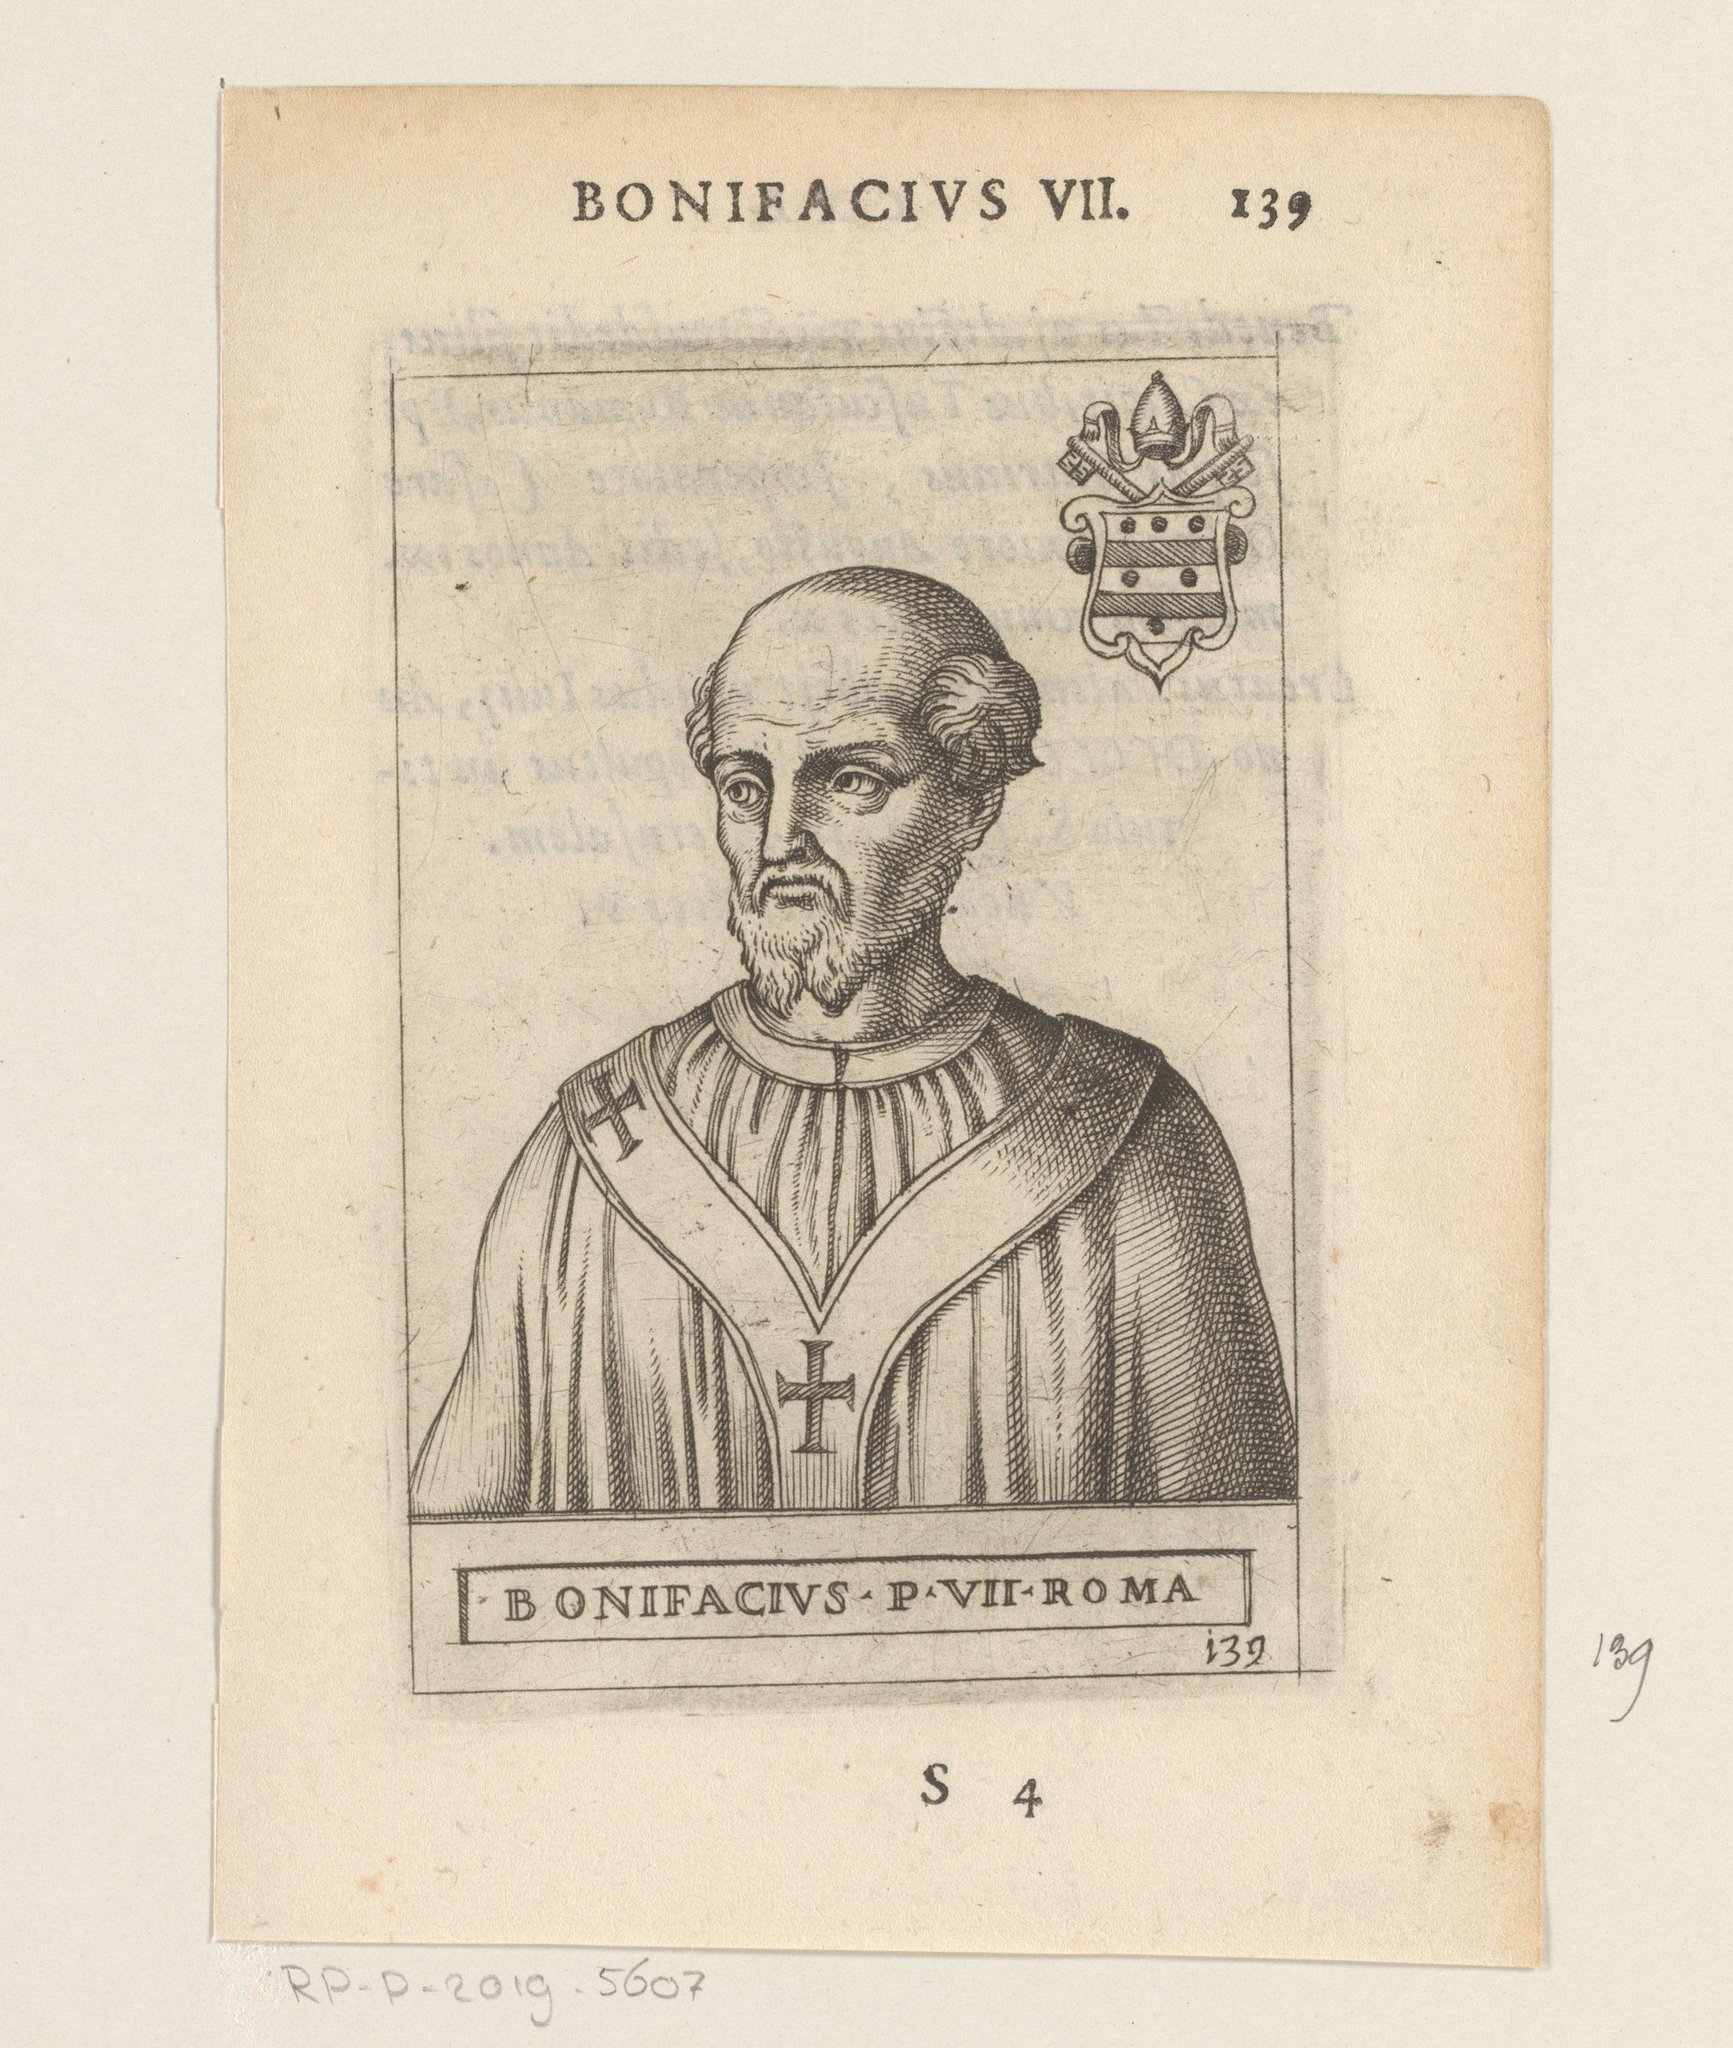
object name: print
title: Portret van tegenpaus Bonifatius VII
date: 1595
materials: paper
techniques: engraving, letterpress printing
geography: rome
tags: historical persons, pope, armorial bearing, heraldry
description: Prent uit: Cavalieri, Giovanni Battista de'. Effigies pontificum romanorum cum eorum vitis (...). Rome: Bartolomeo Bonfadino, 1595. Prent voor het eerst verschenen in: Cavalieri, Giovanni Battista de'. Pontificum romanorum effigies (...). Rome: Domenico Basa en Francesco Zanetti, 1580. Prent ook gebruikt in latere publicaties.